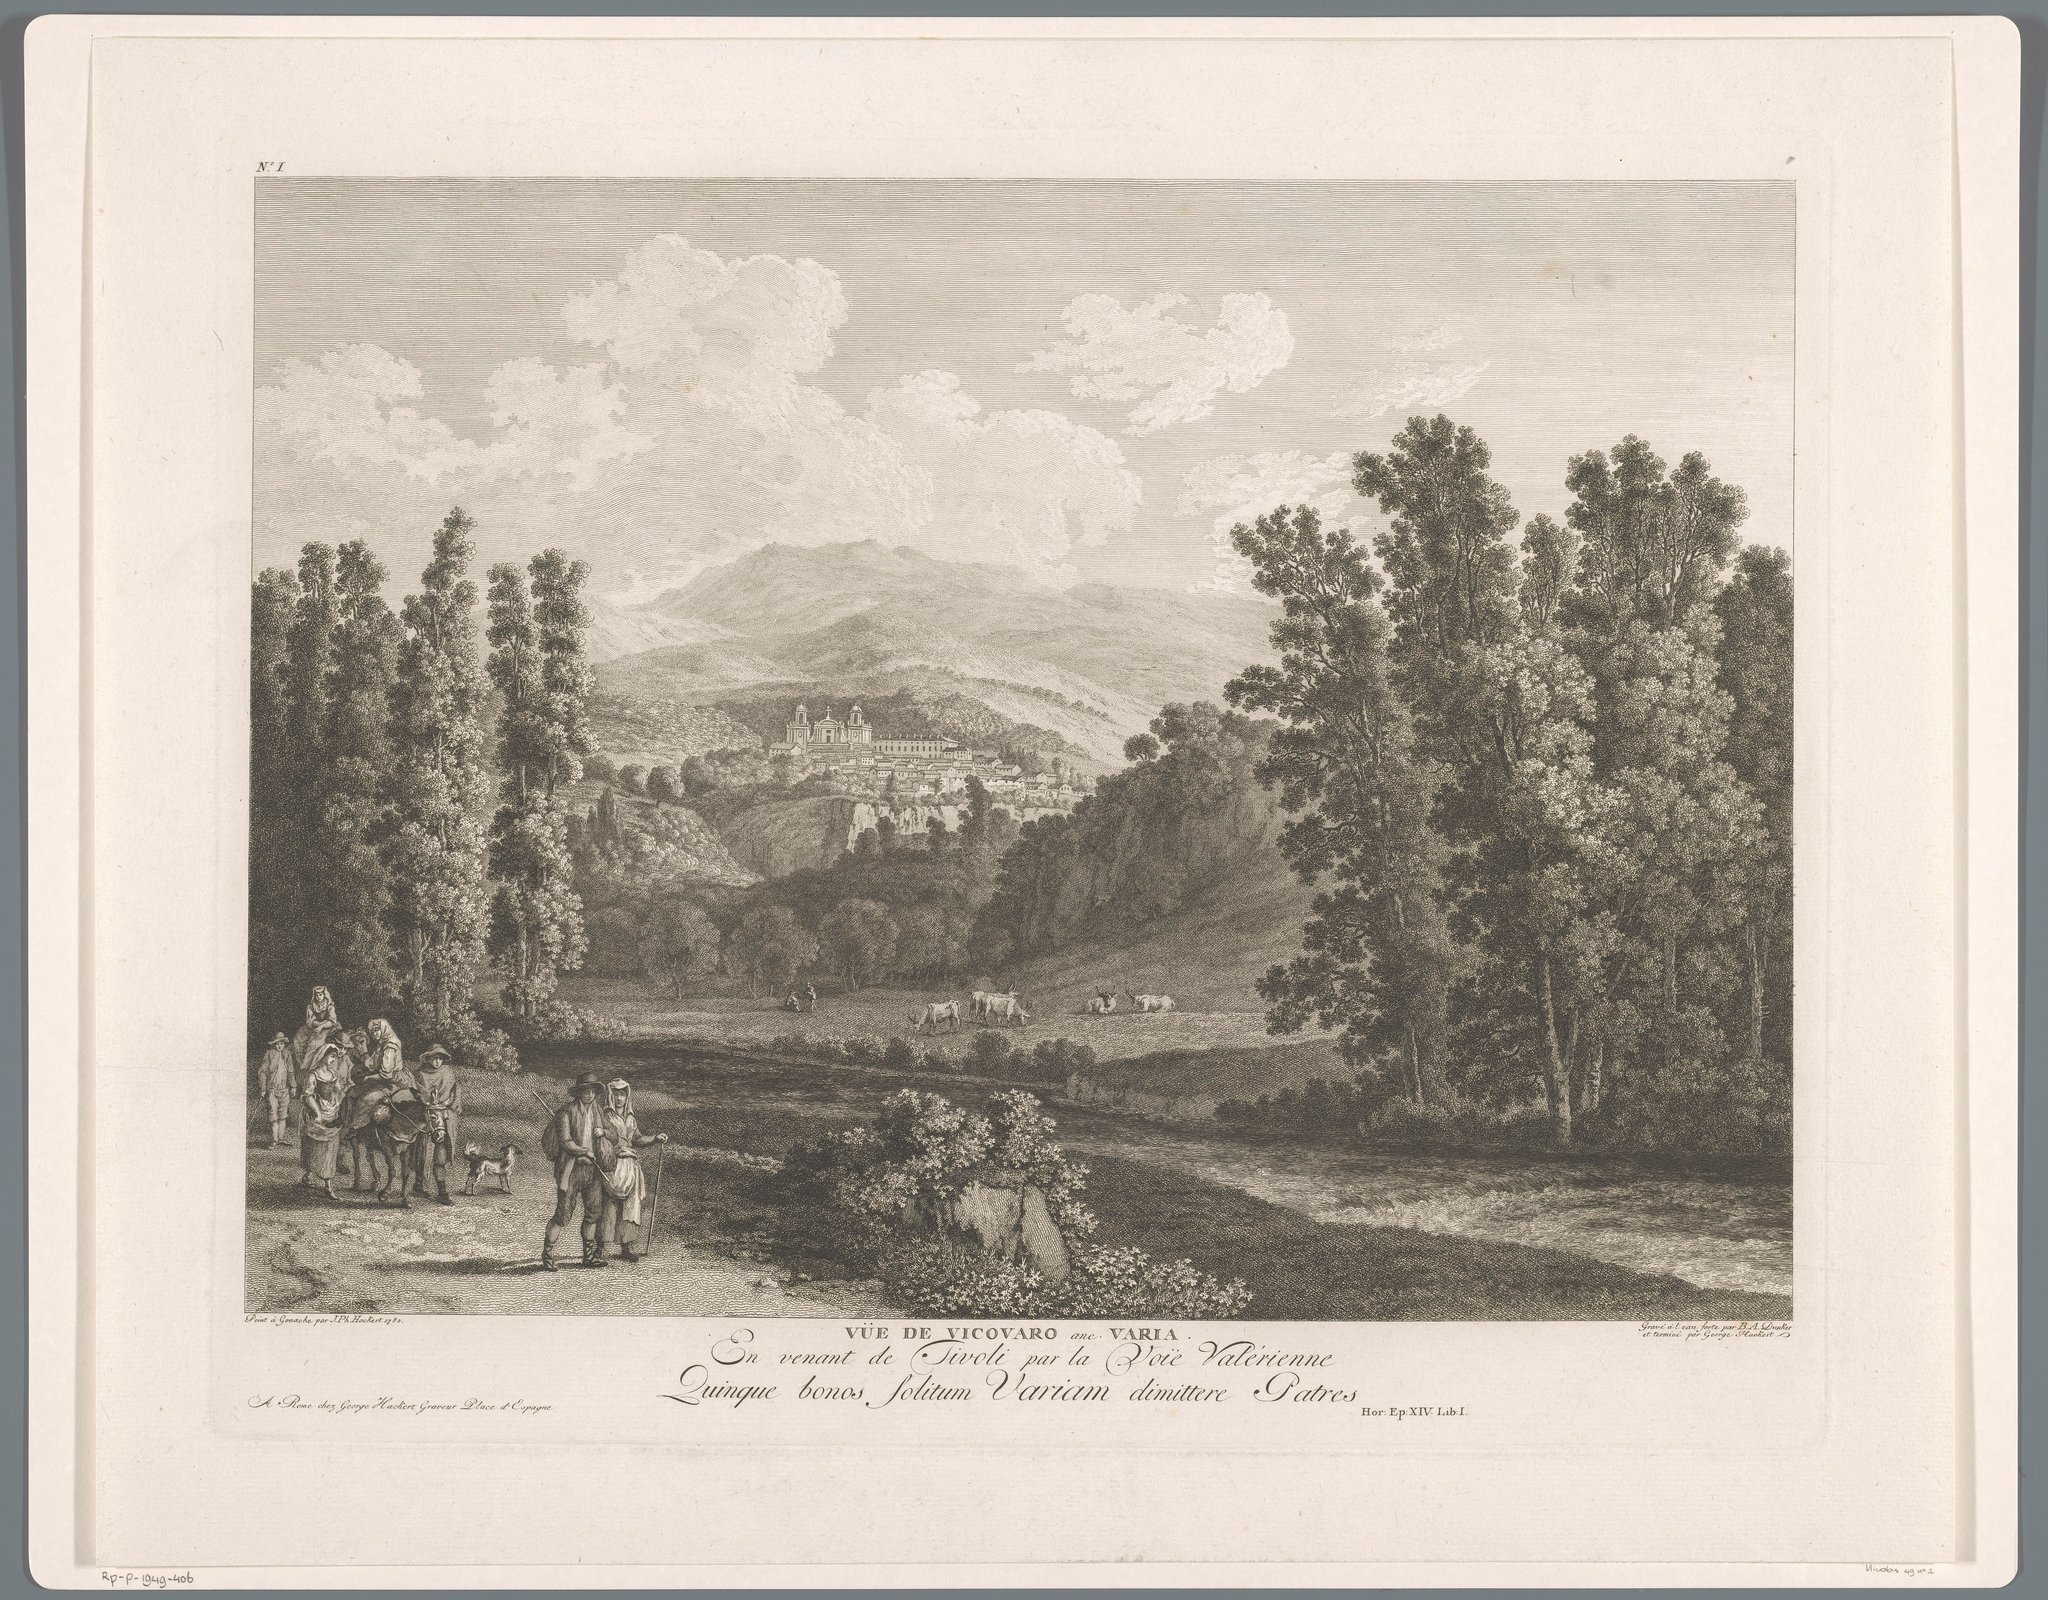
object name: print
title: Vue de Vicovaro anc. Varia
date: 1780-1805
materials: paper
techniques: etching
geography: rome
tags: landscapes, herding, herdsman, herdswoman, shepherd, shepherdess, cowherd, etc., cattle, village, 'en route', traveller under way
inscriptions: collector's mark: Lugt 2228